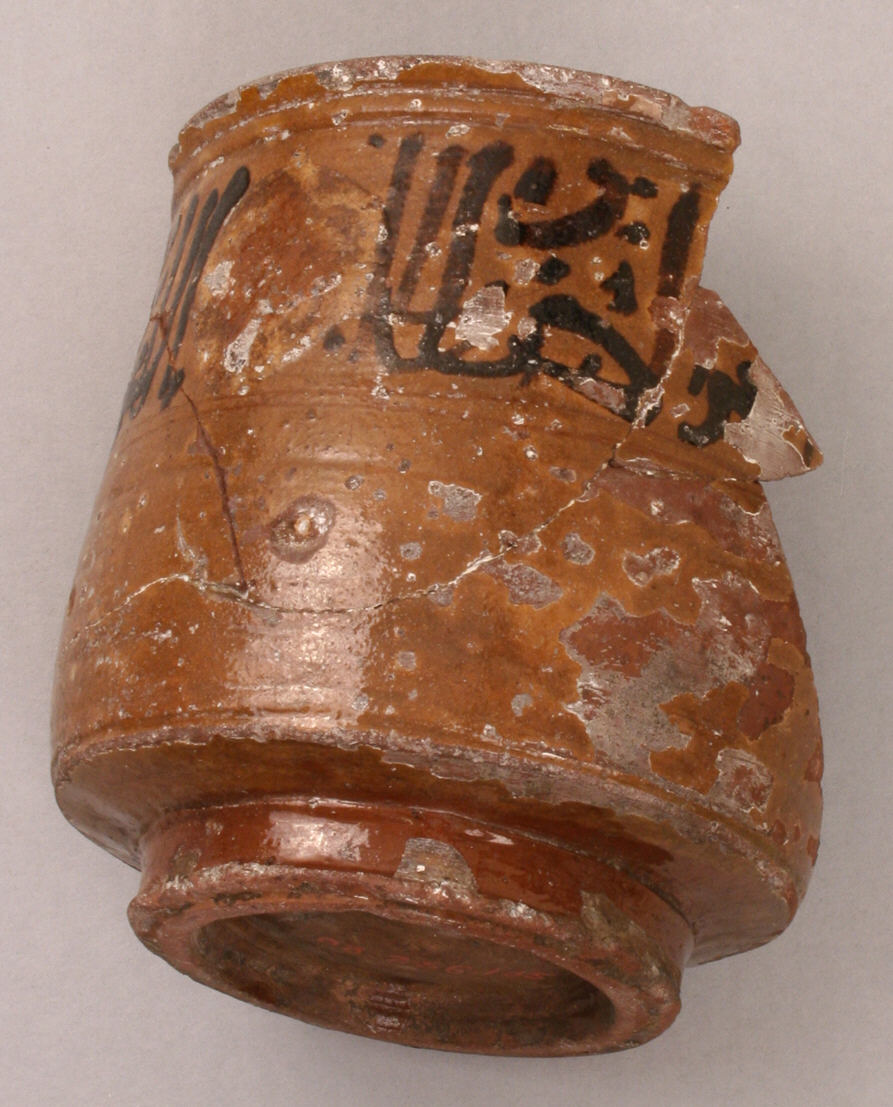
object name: fragment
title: Fragment of a Cup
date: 1301-1500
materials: earthenware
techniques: glazing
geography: egypt